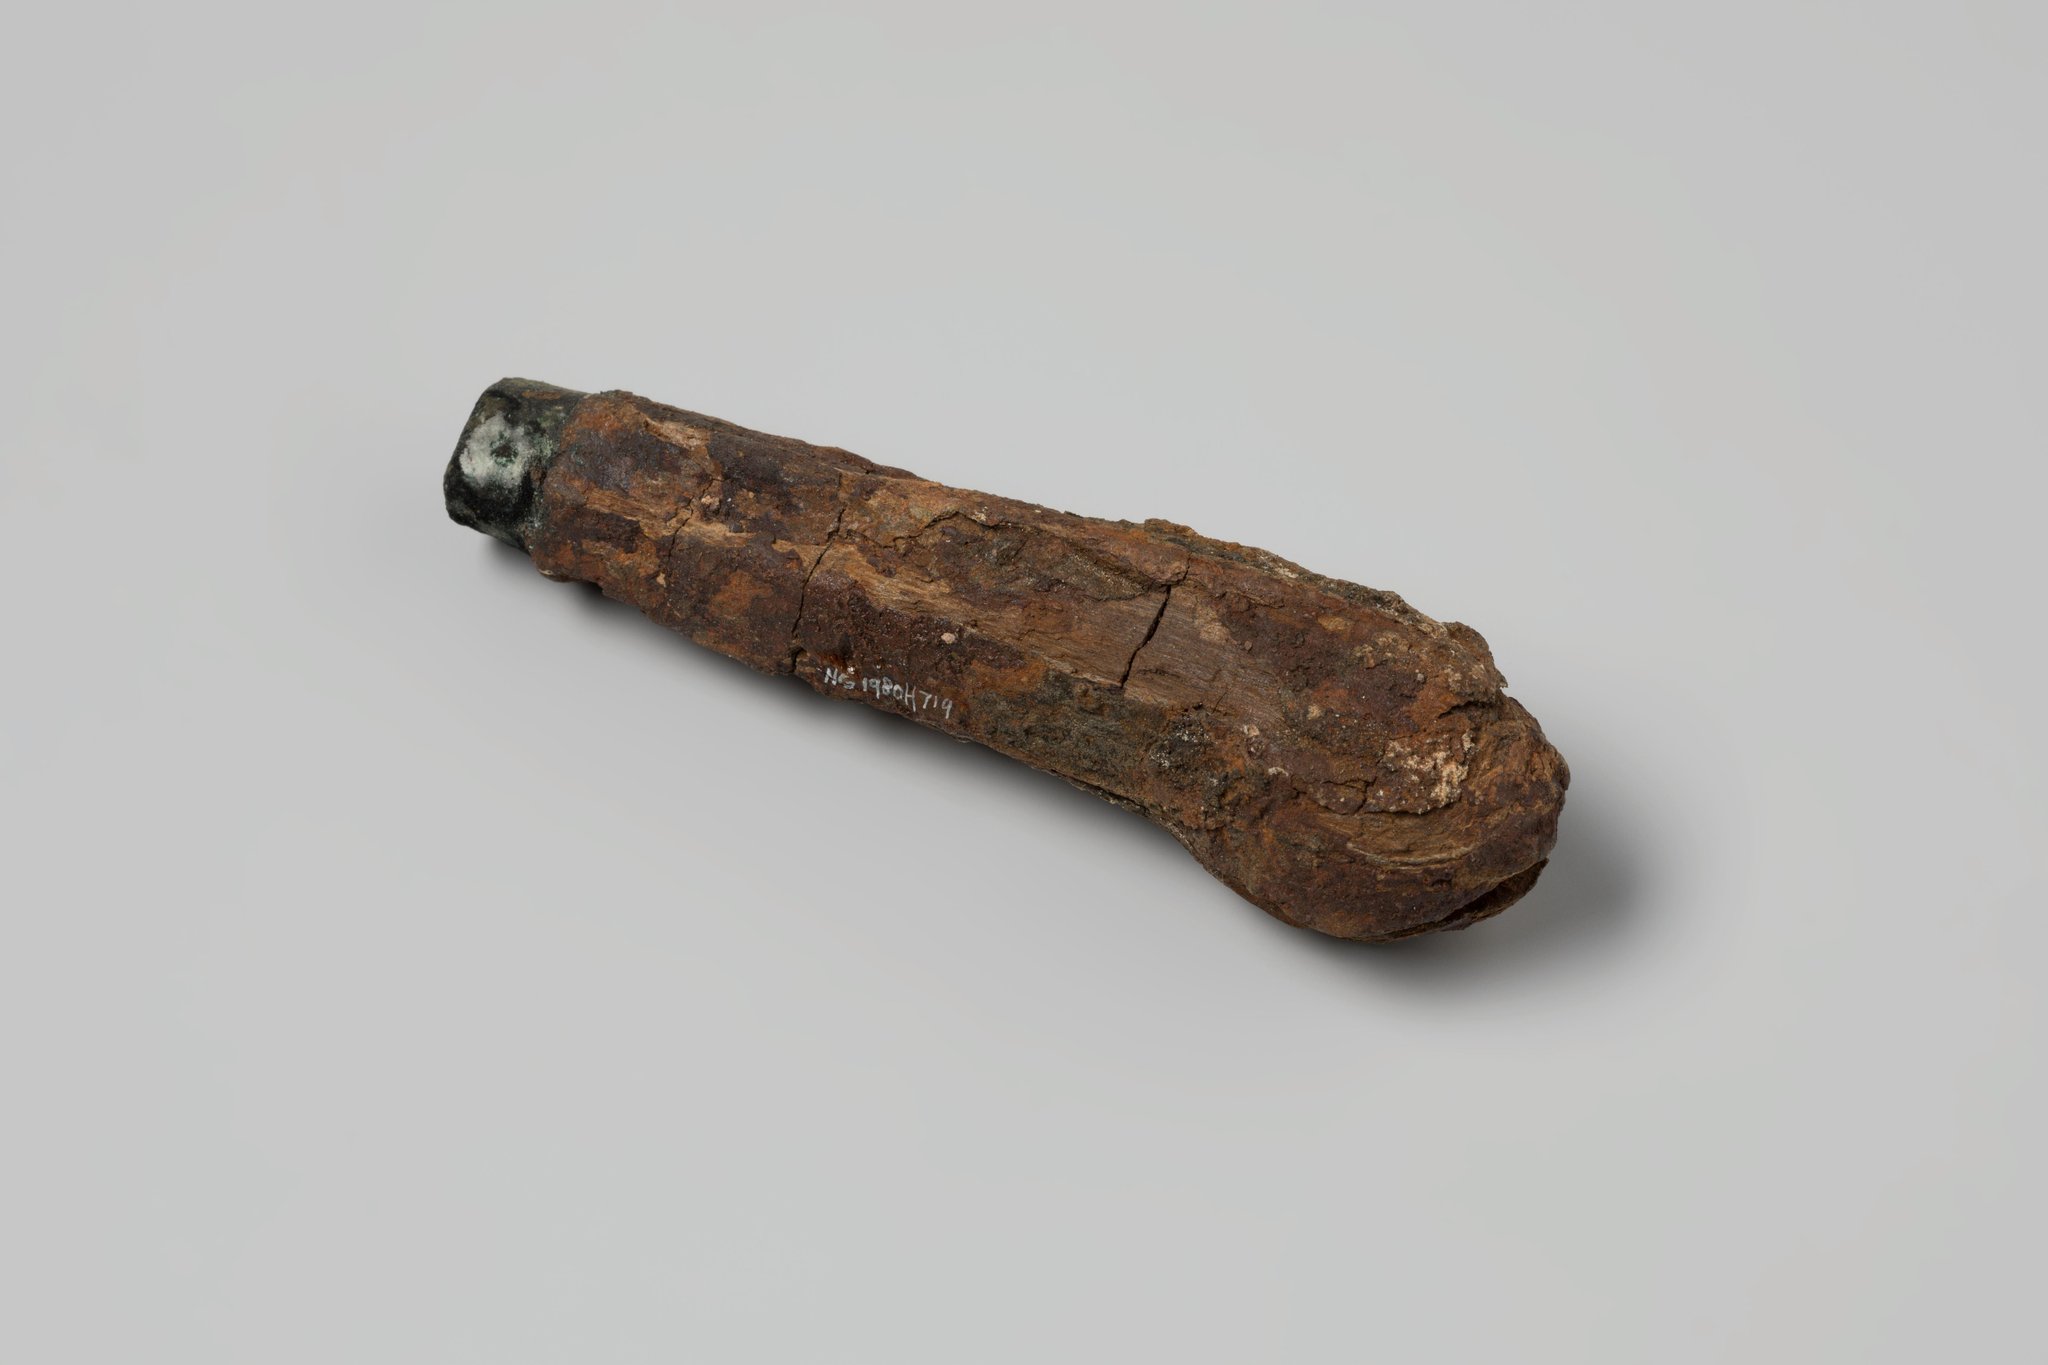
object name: knife tool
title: Messenheft uit het wrak van de Oost-Indiëvaarder Hollandia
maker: Anonymous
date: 1700-1743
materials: metal, wood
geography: netherlands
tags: verenigde oostindische compagnie, hollandia (schip), annet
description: Knife, pistol-grip-shaped fragm id. NG 1979-260H2233.